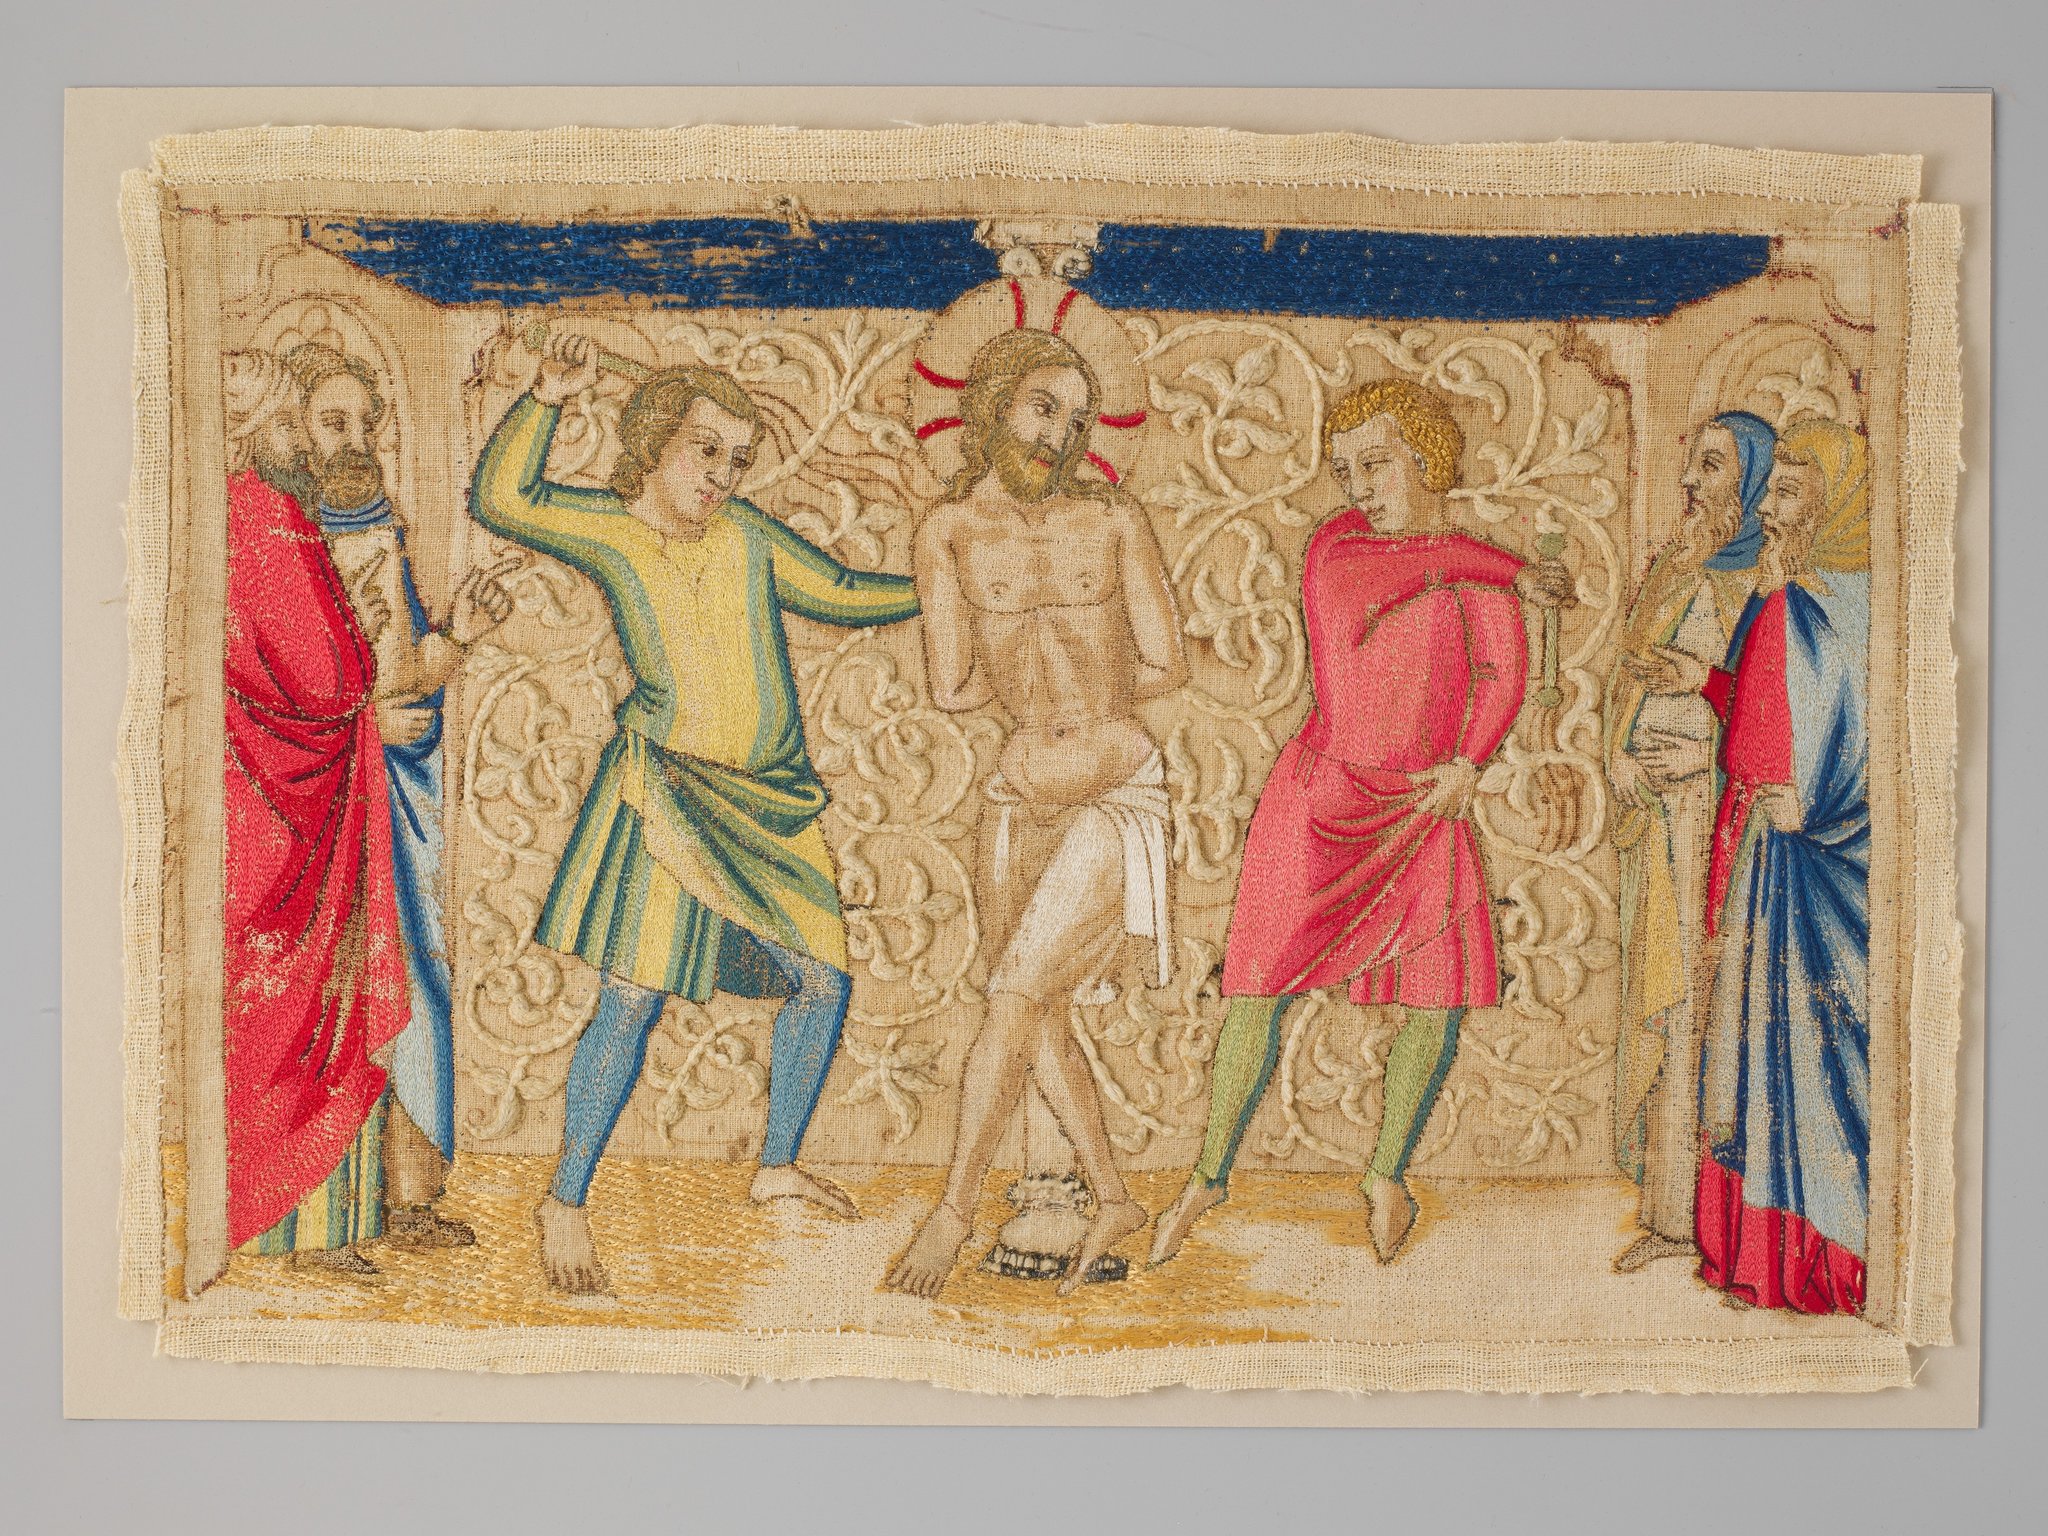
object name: altar frontal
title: The Flagellation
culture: italian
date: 1334-1366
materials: linen, silk, thread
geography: italy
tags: men,christ,flagellation